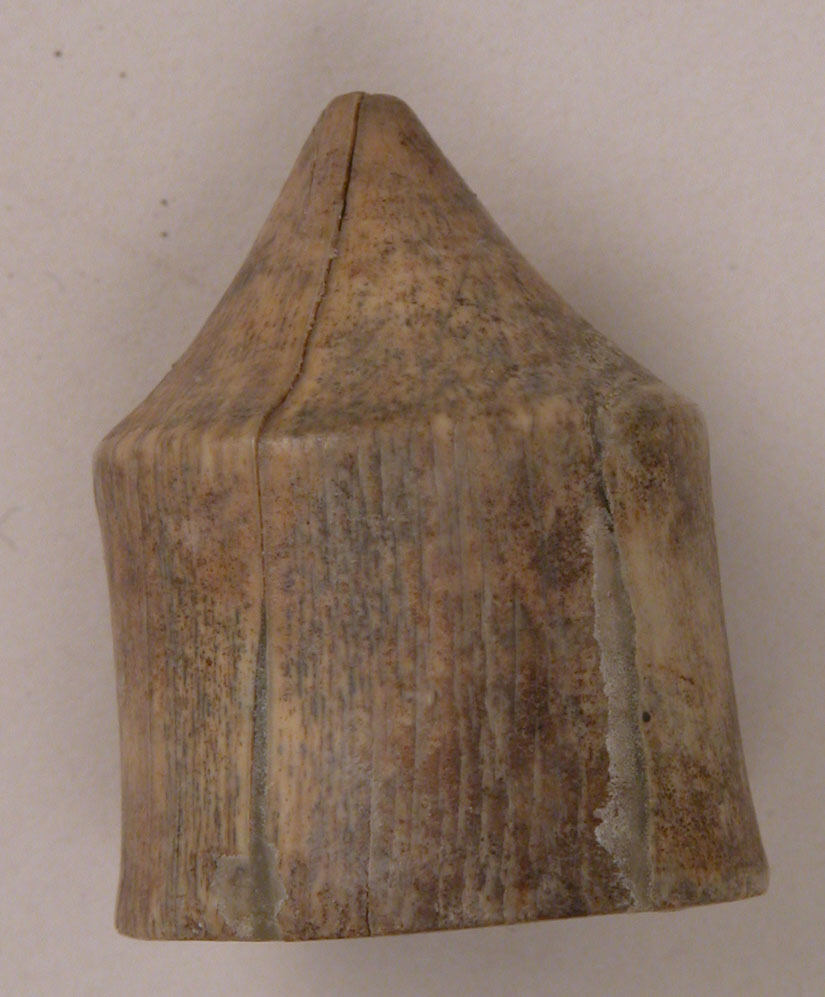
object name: chess piece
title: Chess Piece, Pawn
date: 801-1100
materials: ivory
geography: western islamic lands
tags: chess